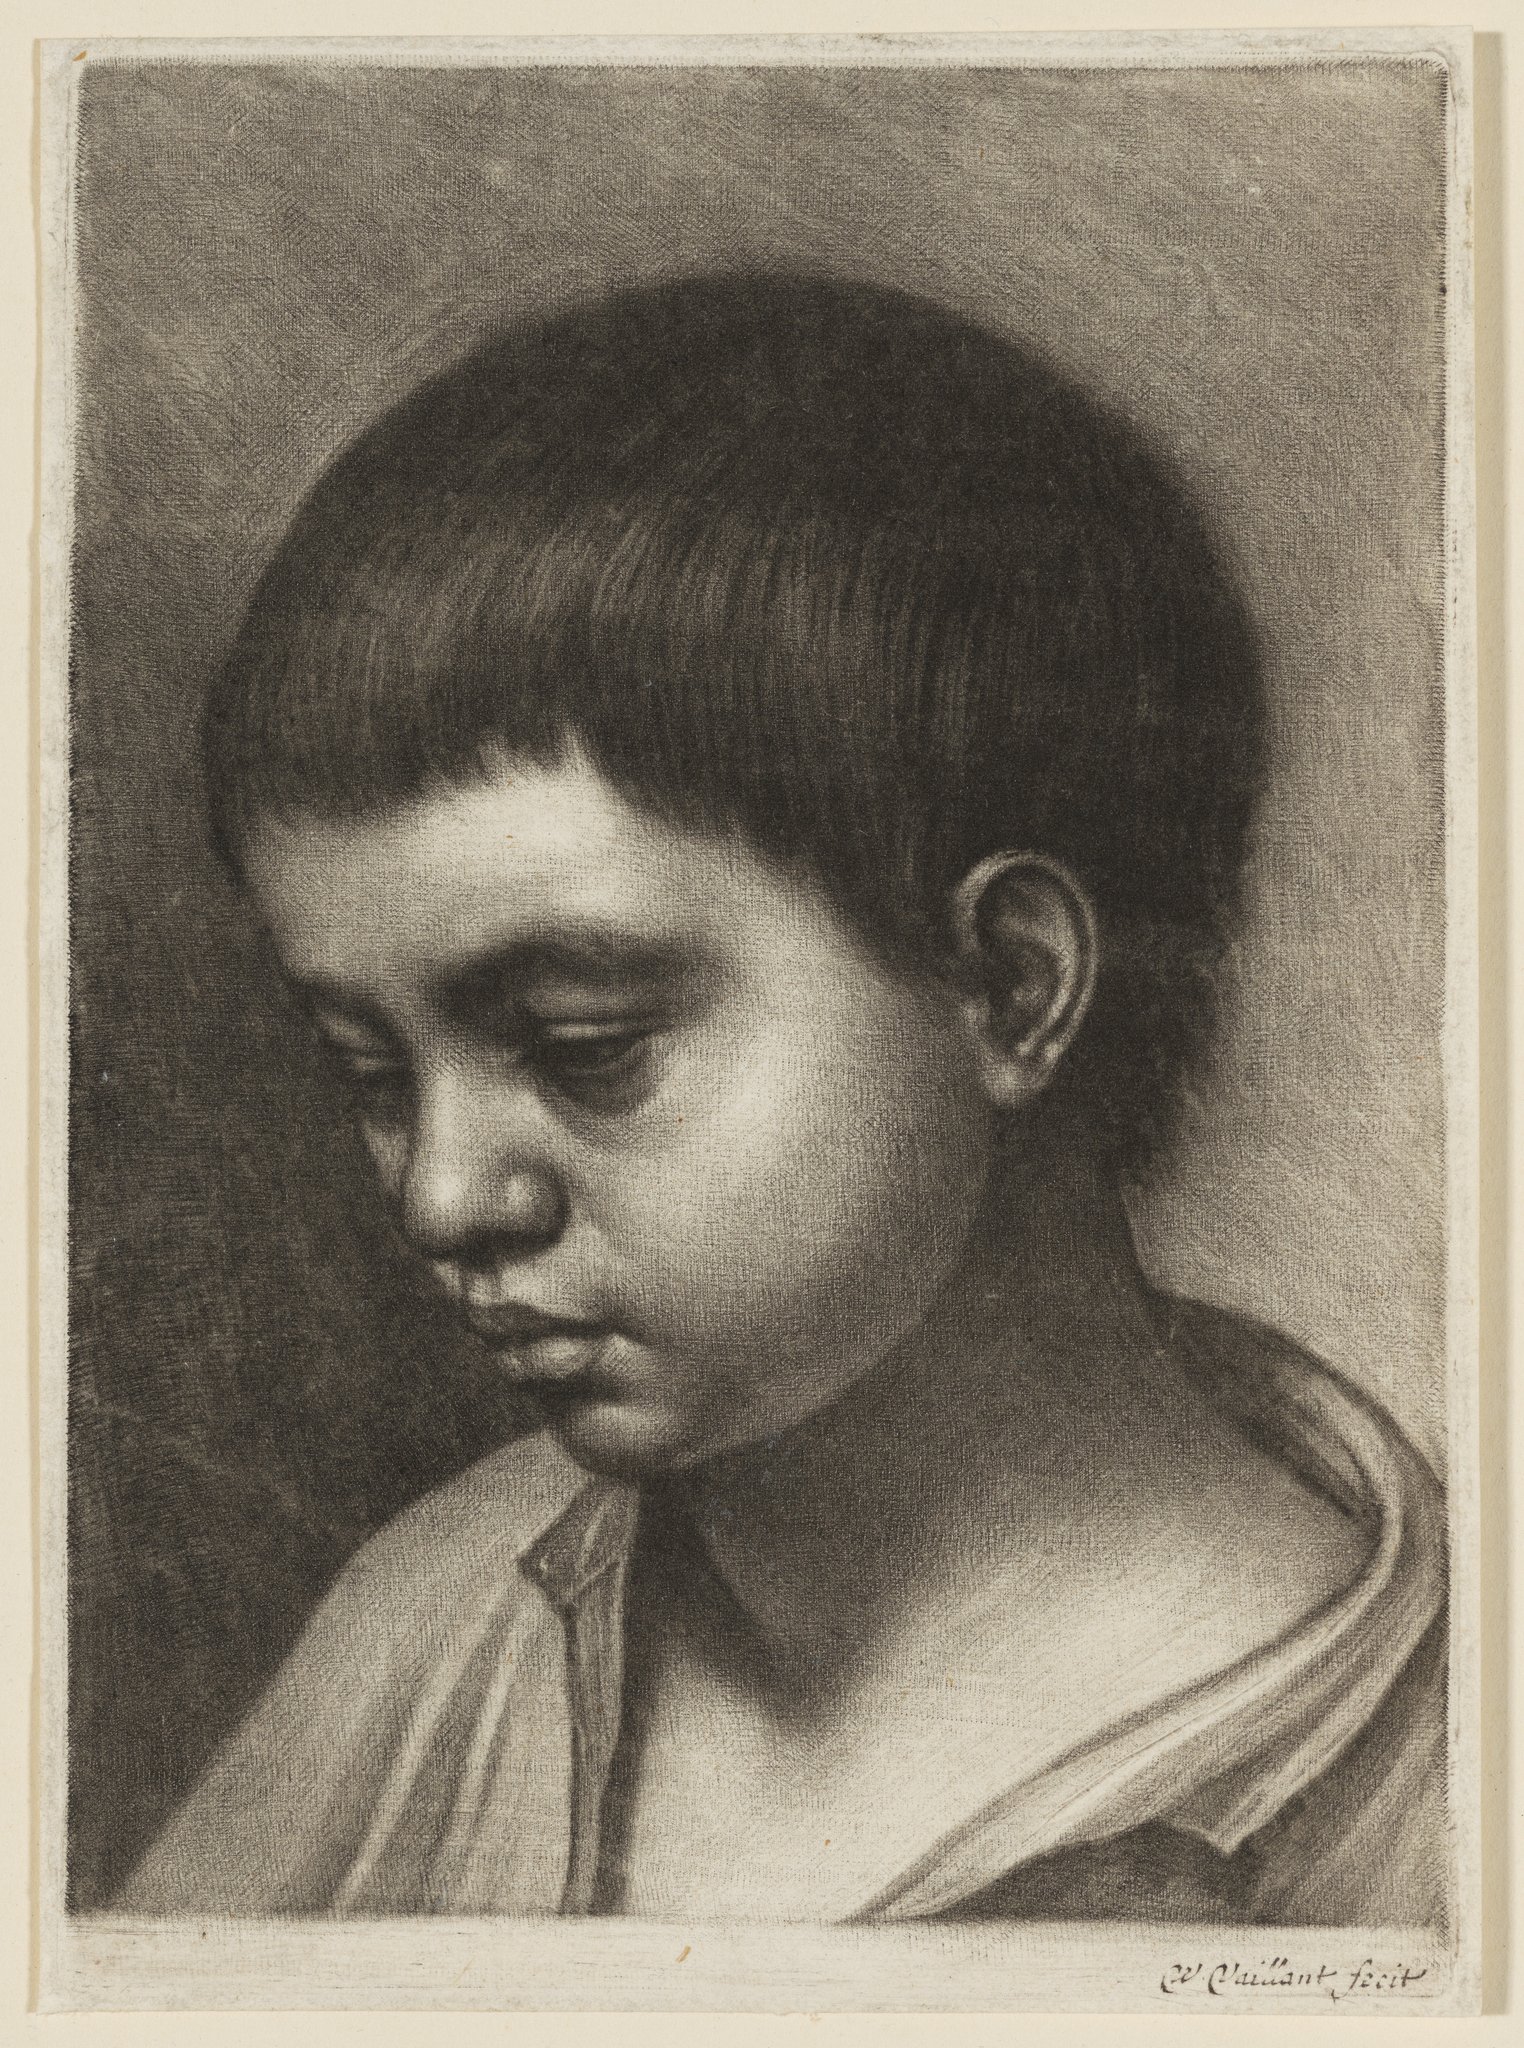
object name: print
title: Head of a Boy, turned to the left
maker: wallerant vaillant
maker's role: artist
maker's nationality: dutch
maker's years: 1623-1677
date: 1601-1700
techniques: mezzotint